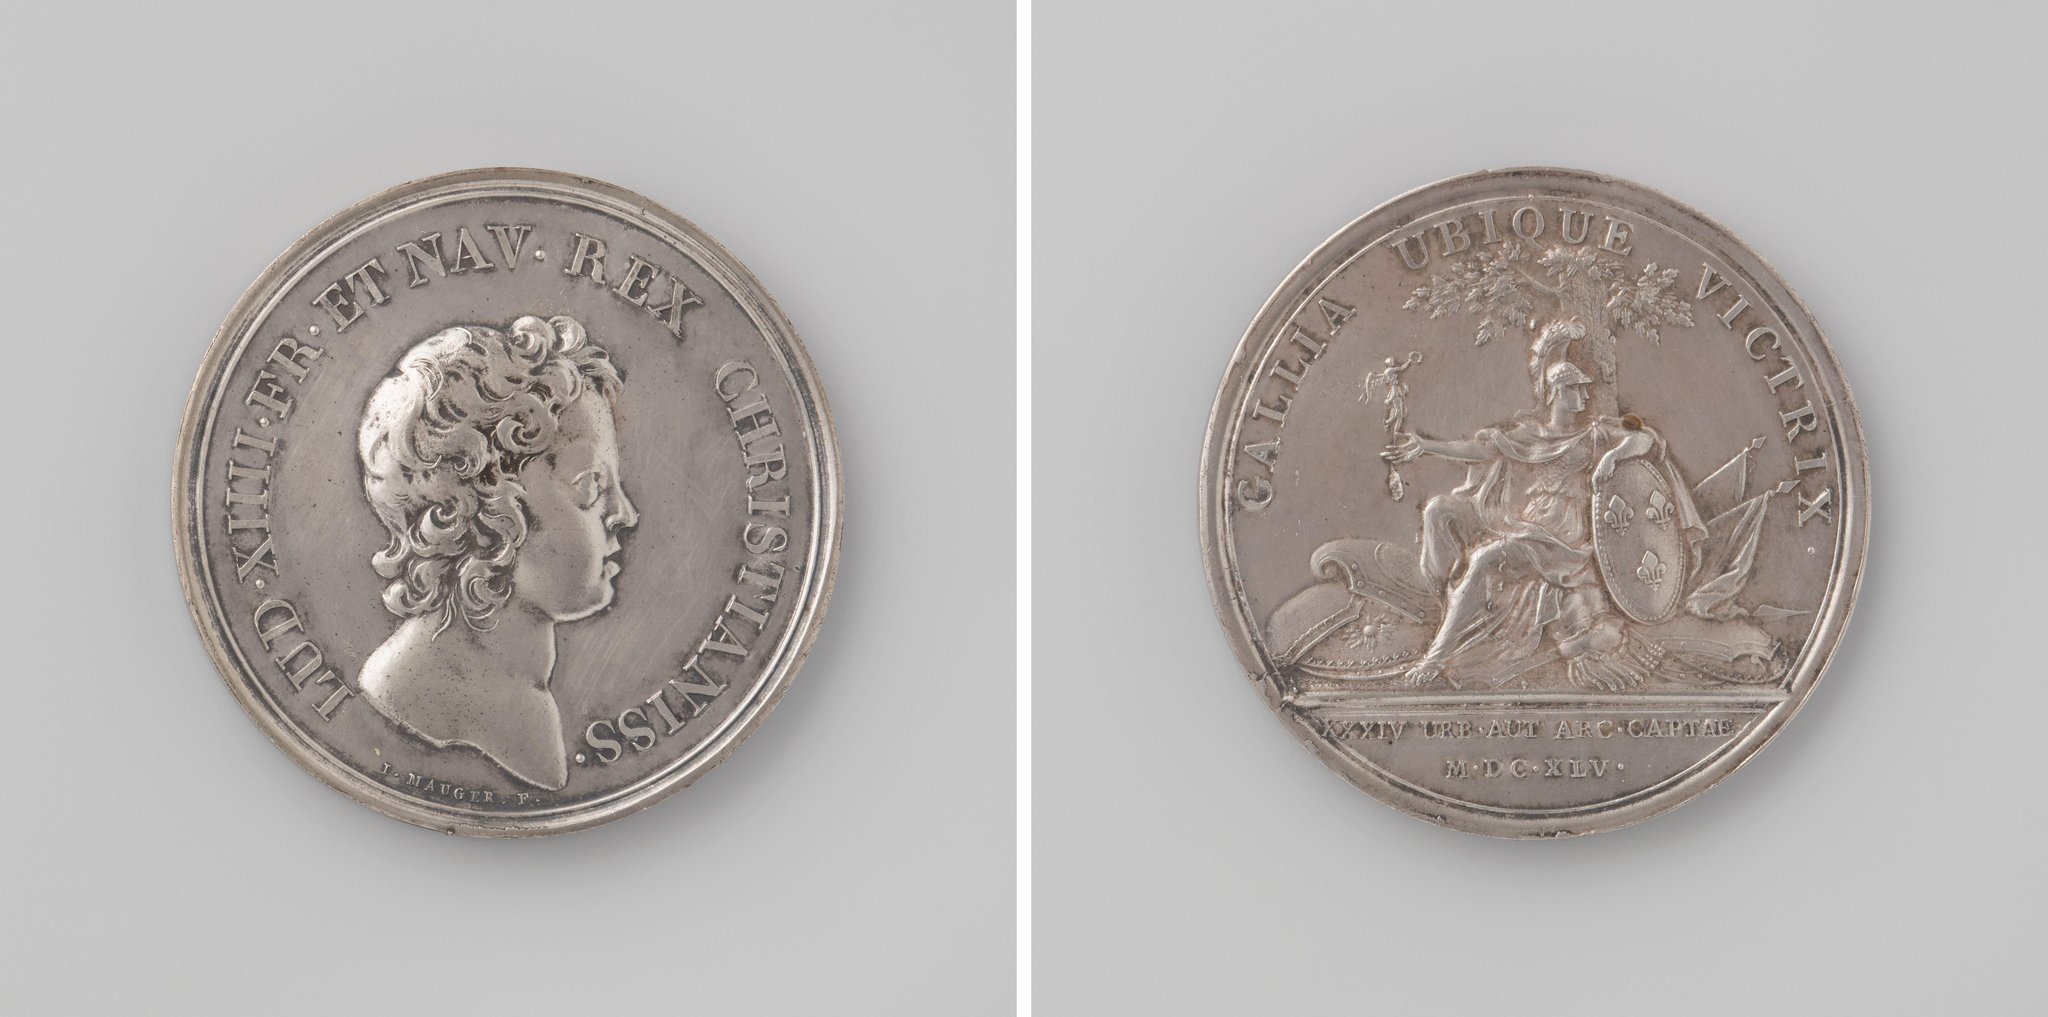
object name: history medal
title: Veroveren van vierendertig steden door de Fransen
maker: jean mauger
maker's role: medailleur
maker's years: 1648-1722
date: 1699-1703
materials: silver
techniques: striking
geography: paris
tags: lodewijk xiv (koning van frankrijk)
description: Zilveren penning. Voorzijde: borststuk jongen (Lodewijk XIV) binnen omschrift. Keerzijde: Frankrijk gezeten onder boom op stapel krijgstuig met overwinningsbeeldje in rechterhand en leunend op wapenschild binnen omschrift